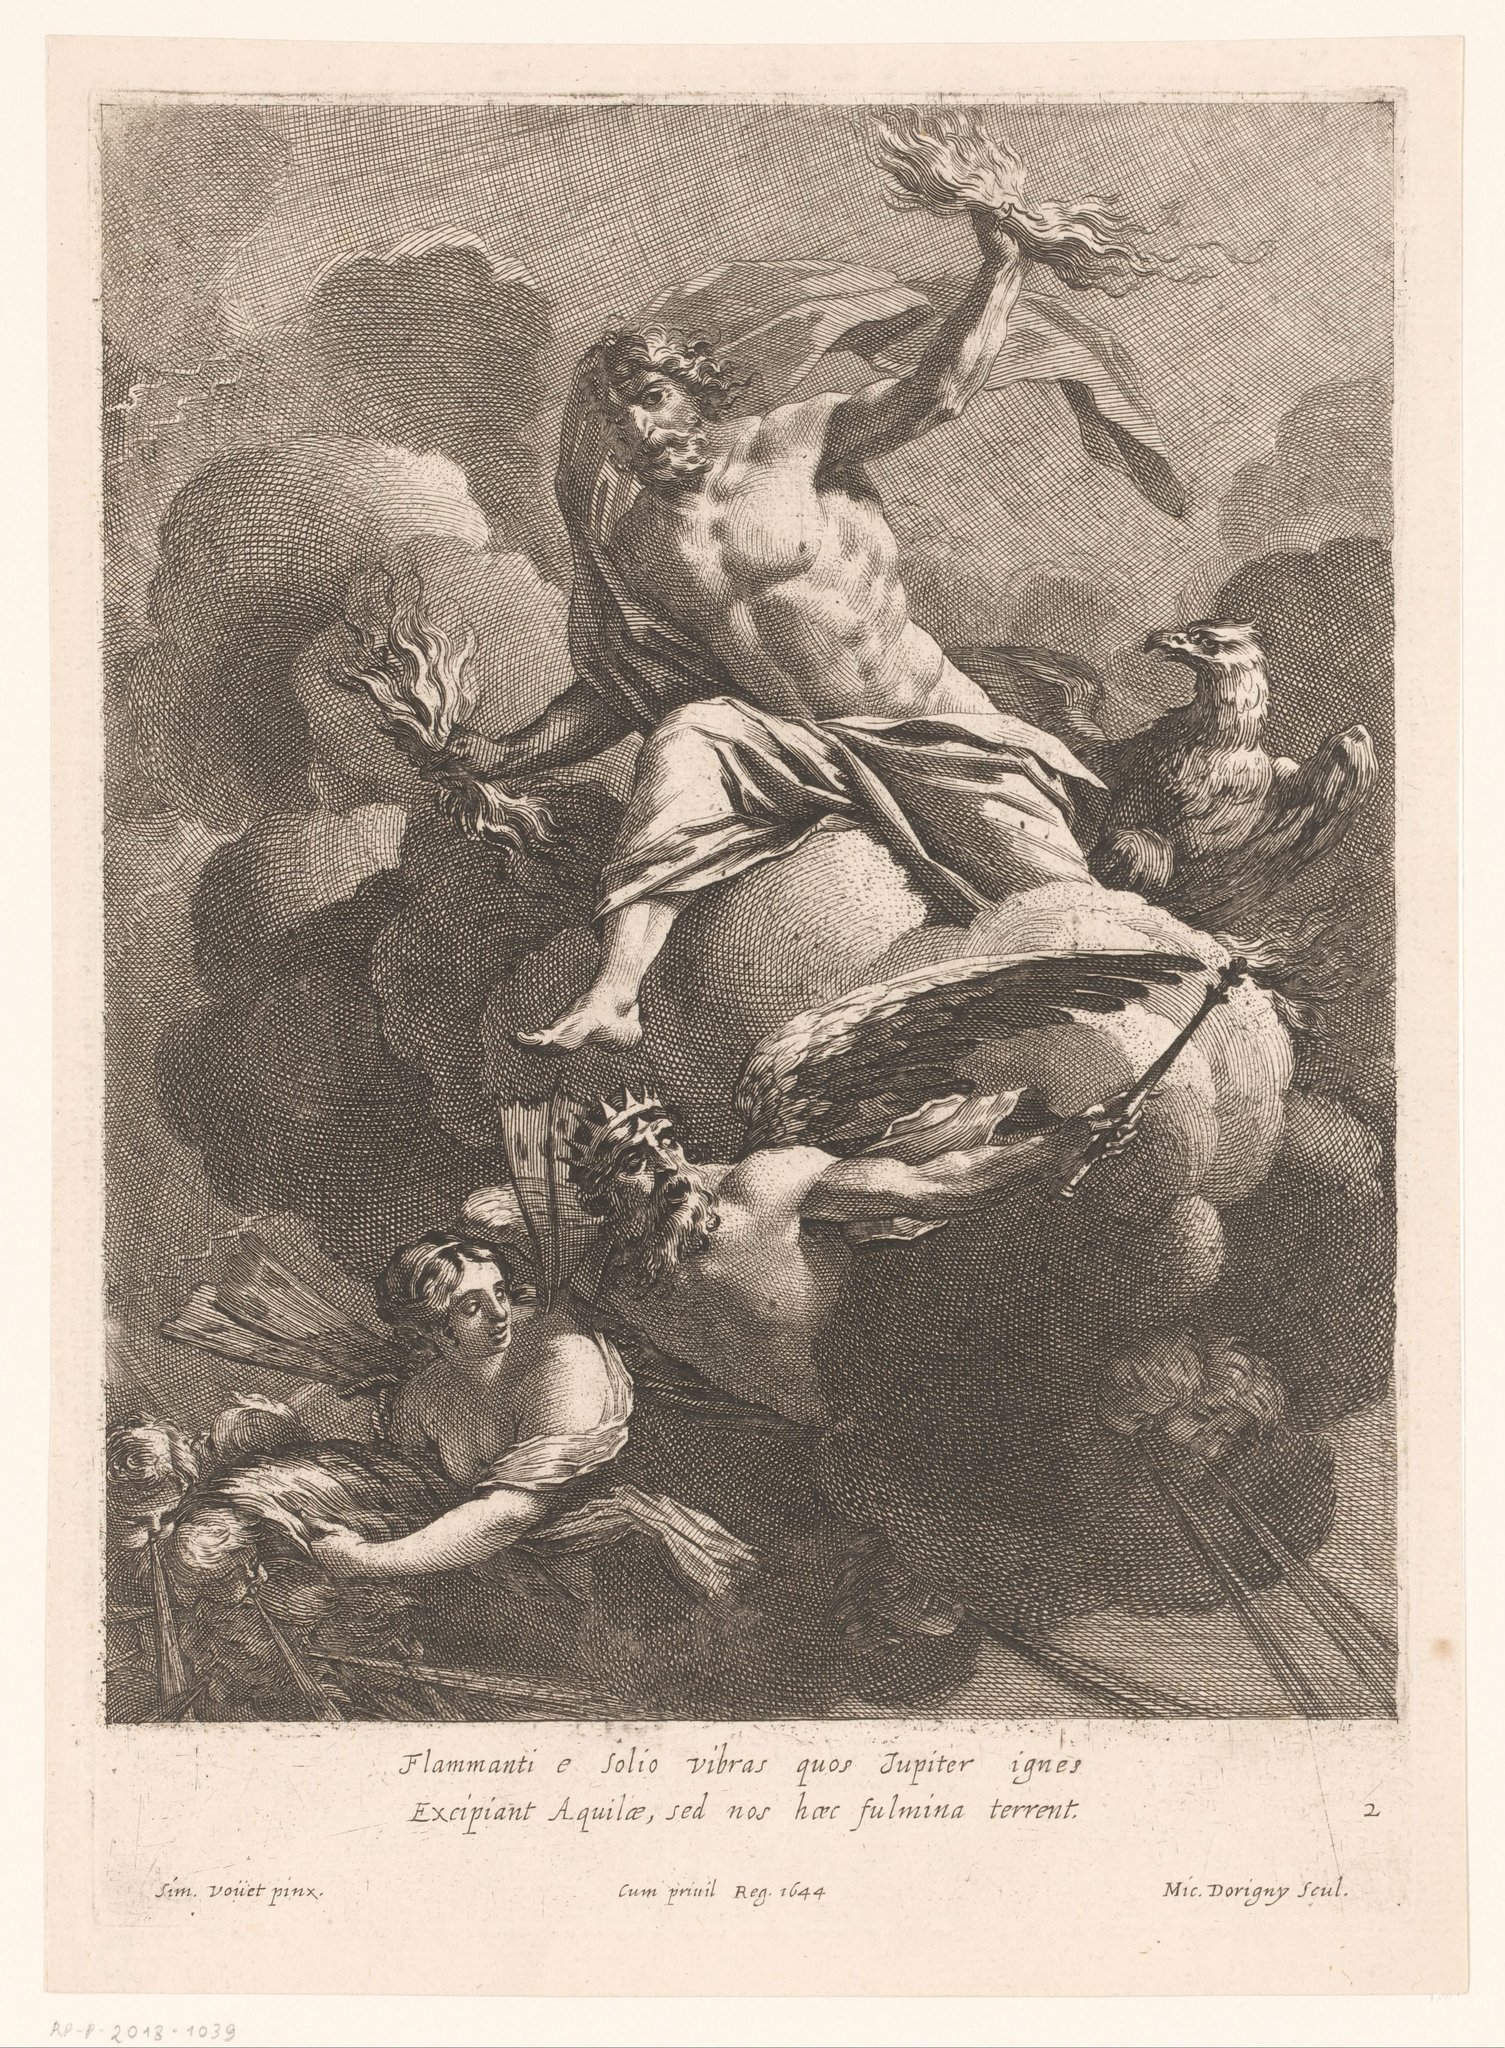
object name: print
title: Serie van prenten naar de schilderijen van Fontainebleau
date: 1644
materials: paper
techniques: engraving, etching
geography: france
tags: (story of) jupiter (zeus), attributes of jupiter: thunderbolt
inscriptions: collector's mark: Lugt 2228